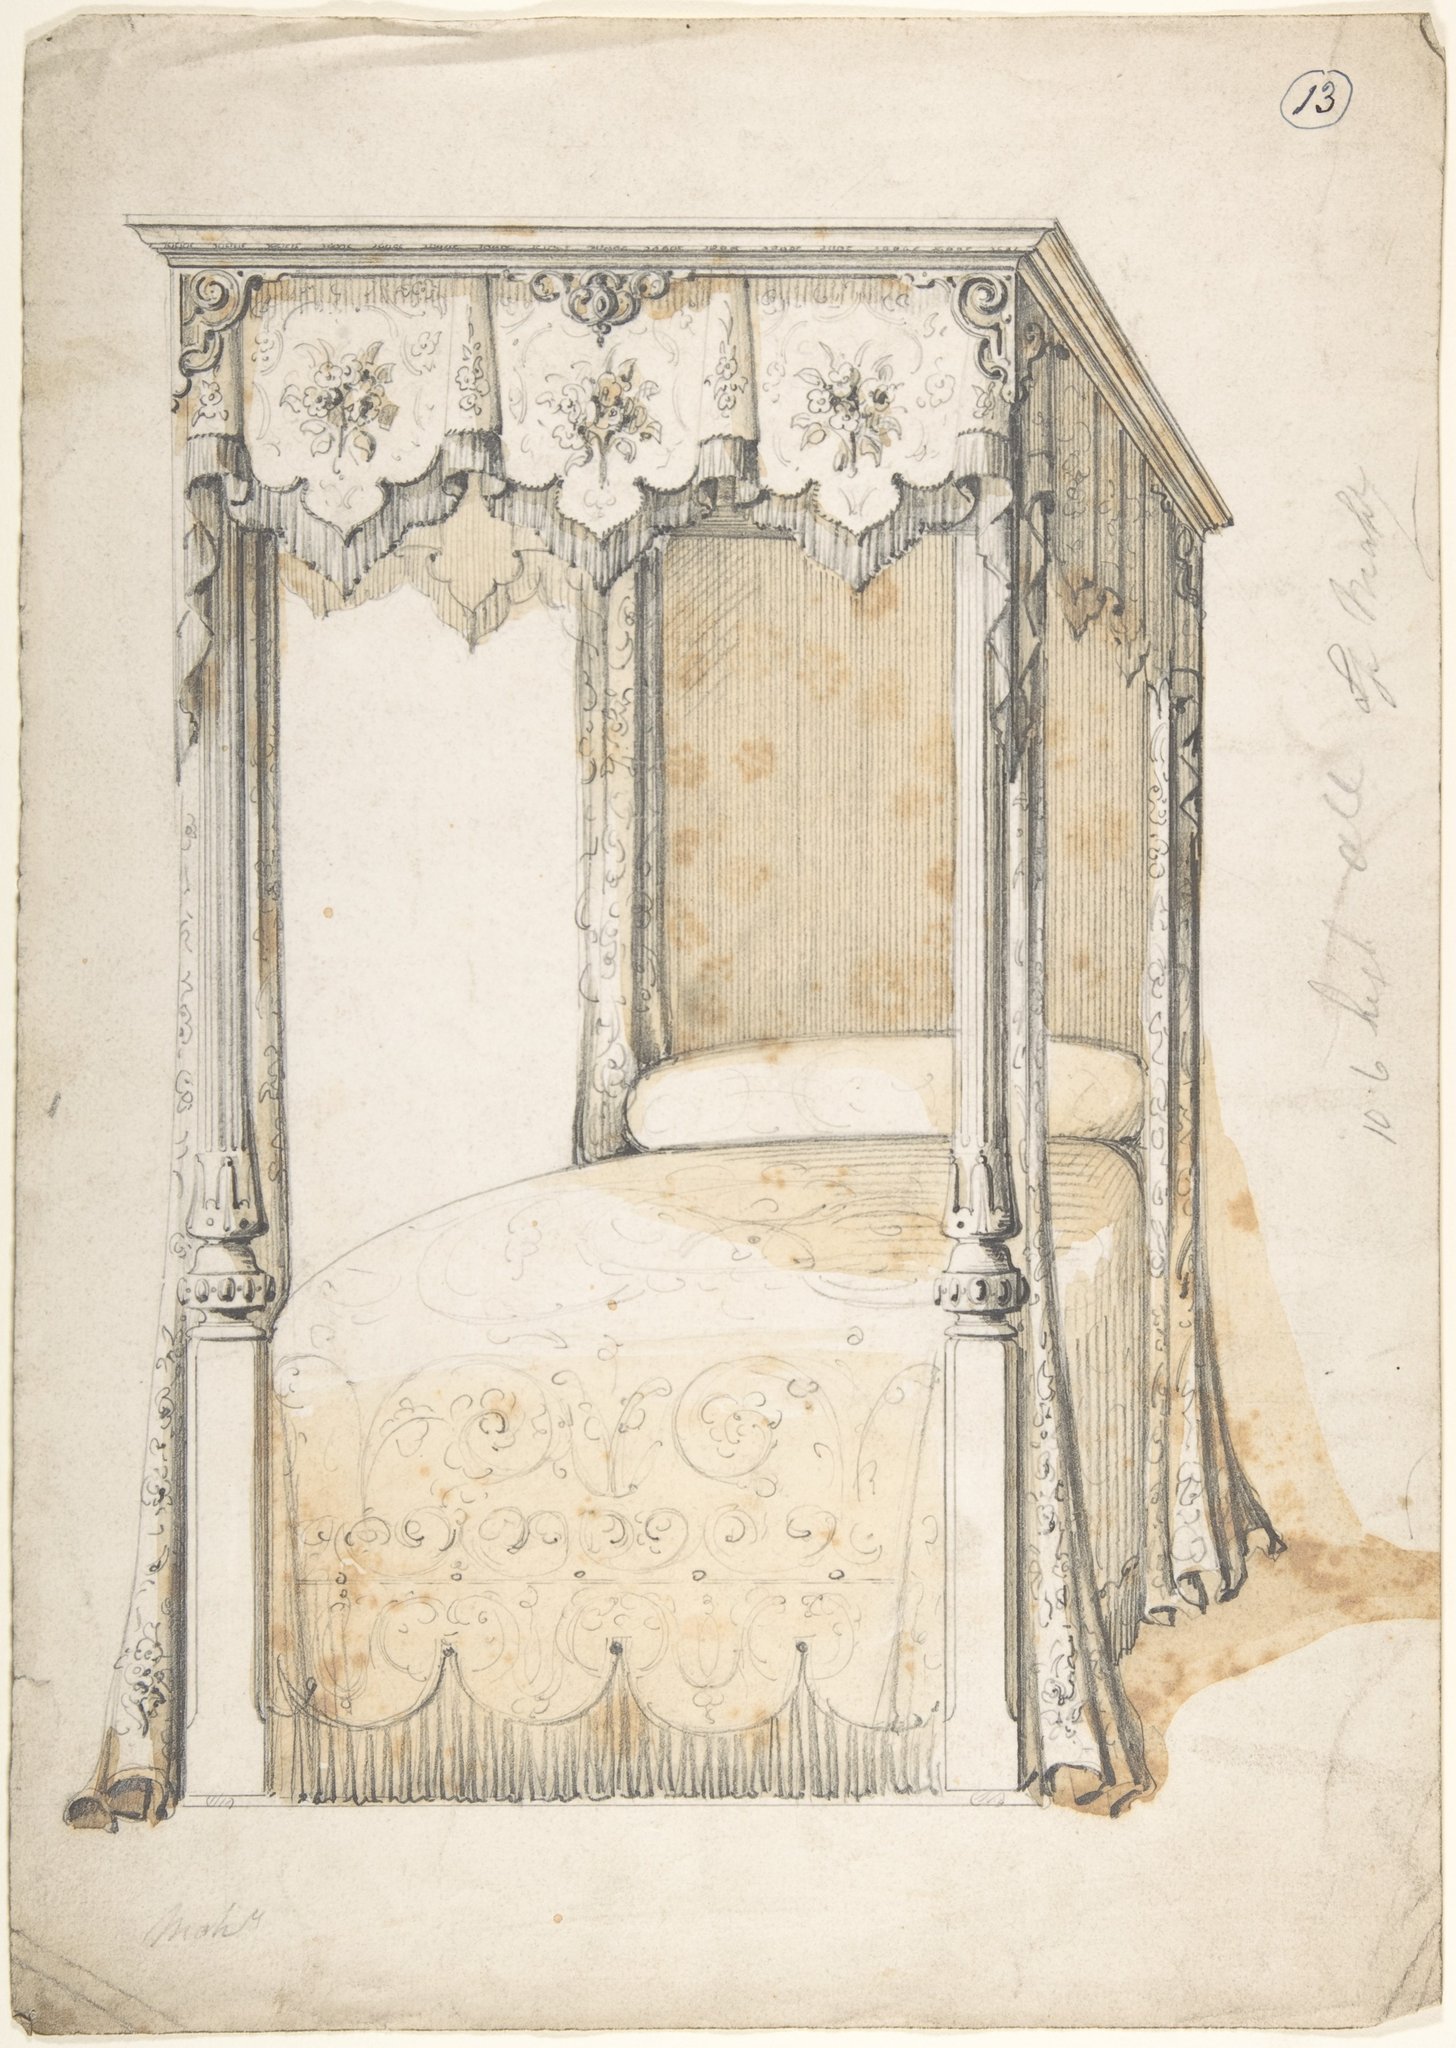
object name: drawing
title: Design for a Bed and Canopy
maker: charles hindley and sons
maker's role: artist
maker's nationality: british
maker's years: 1841-1917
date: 1841-1917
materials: graphite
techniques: brush, wash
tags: beds